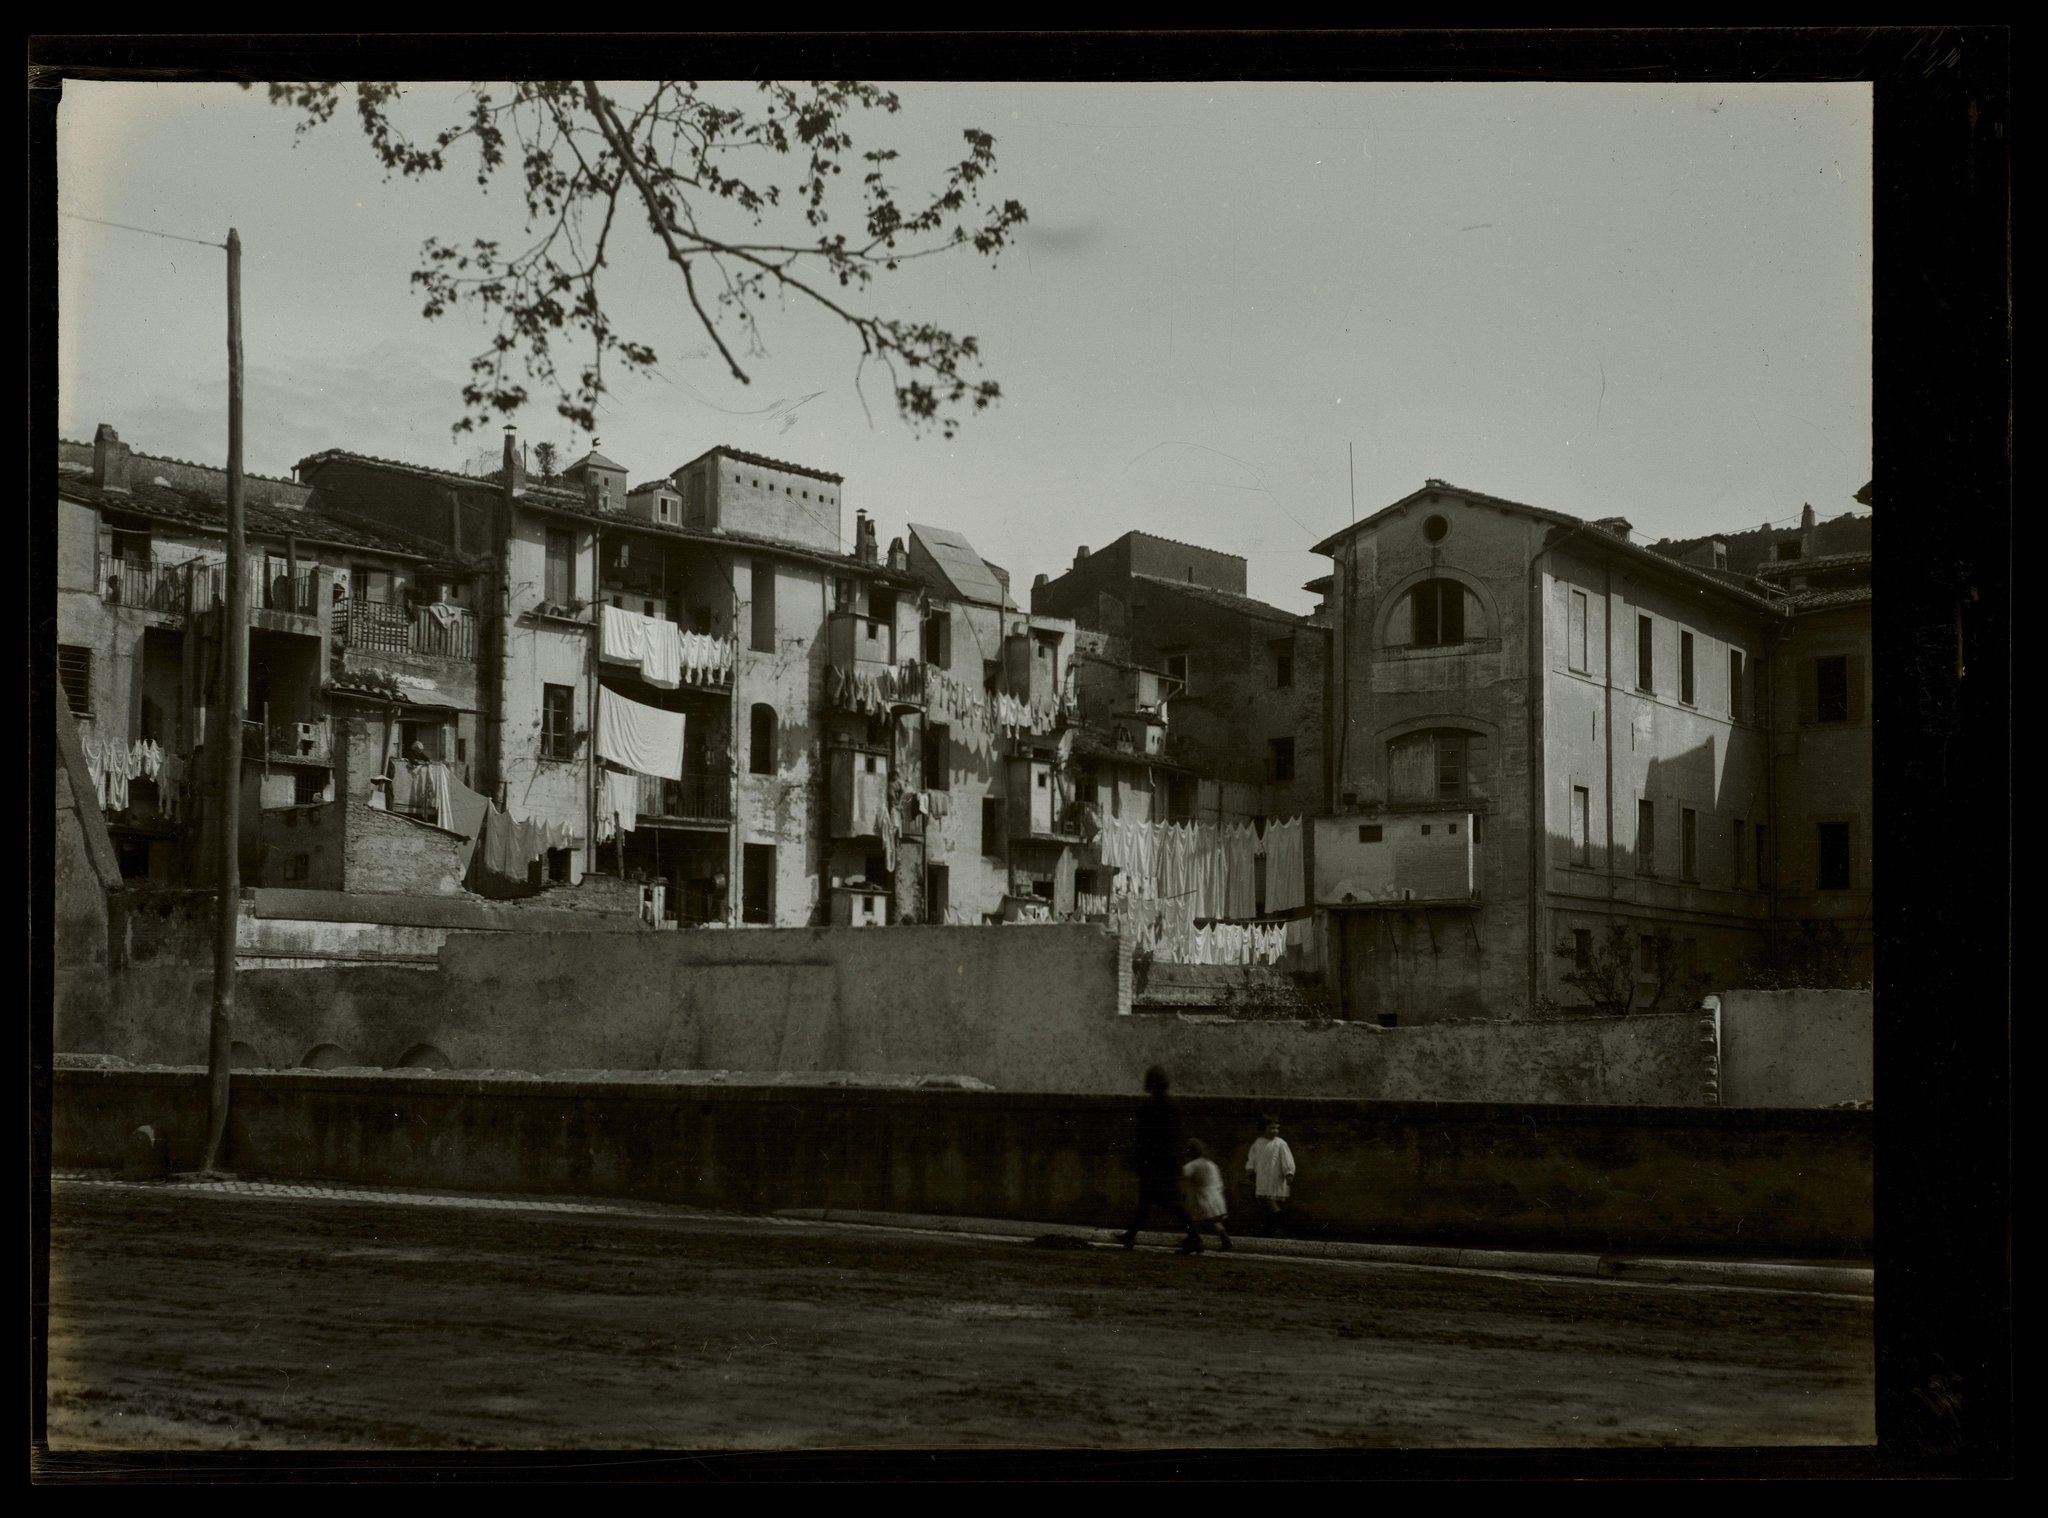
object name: photograph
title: Filmnegatief met opname van Rome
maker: Anonymous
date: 1907-1935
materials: film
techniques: gelatin silver negative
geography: rome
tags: rome